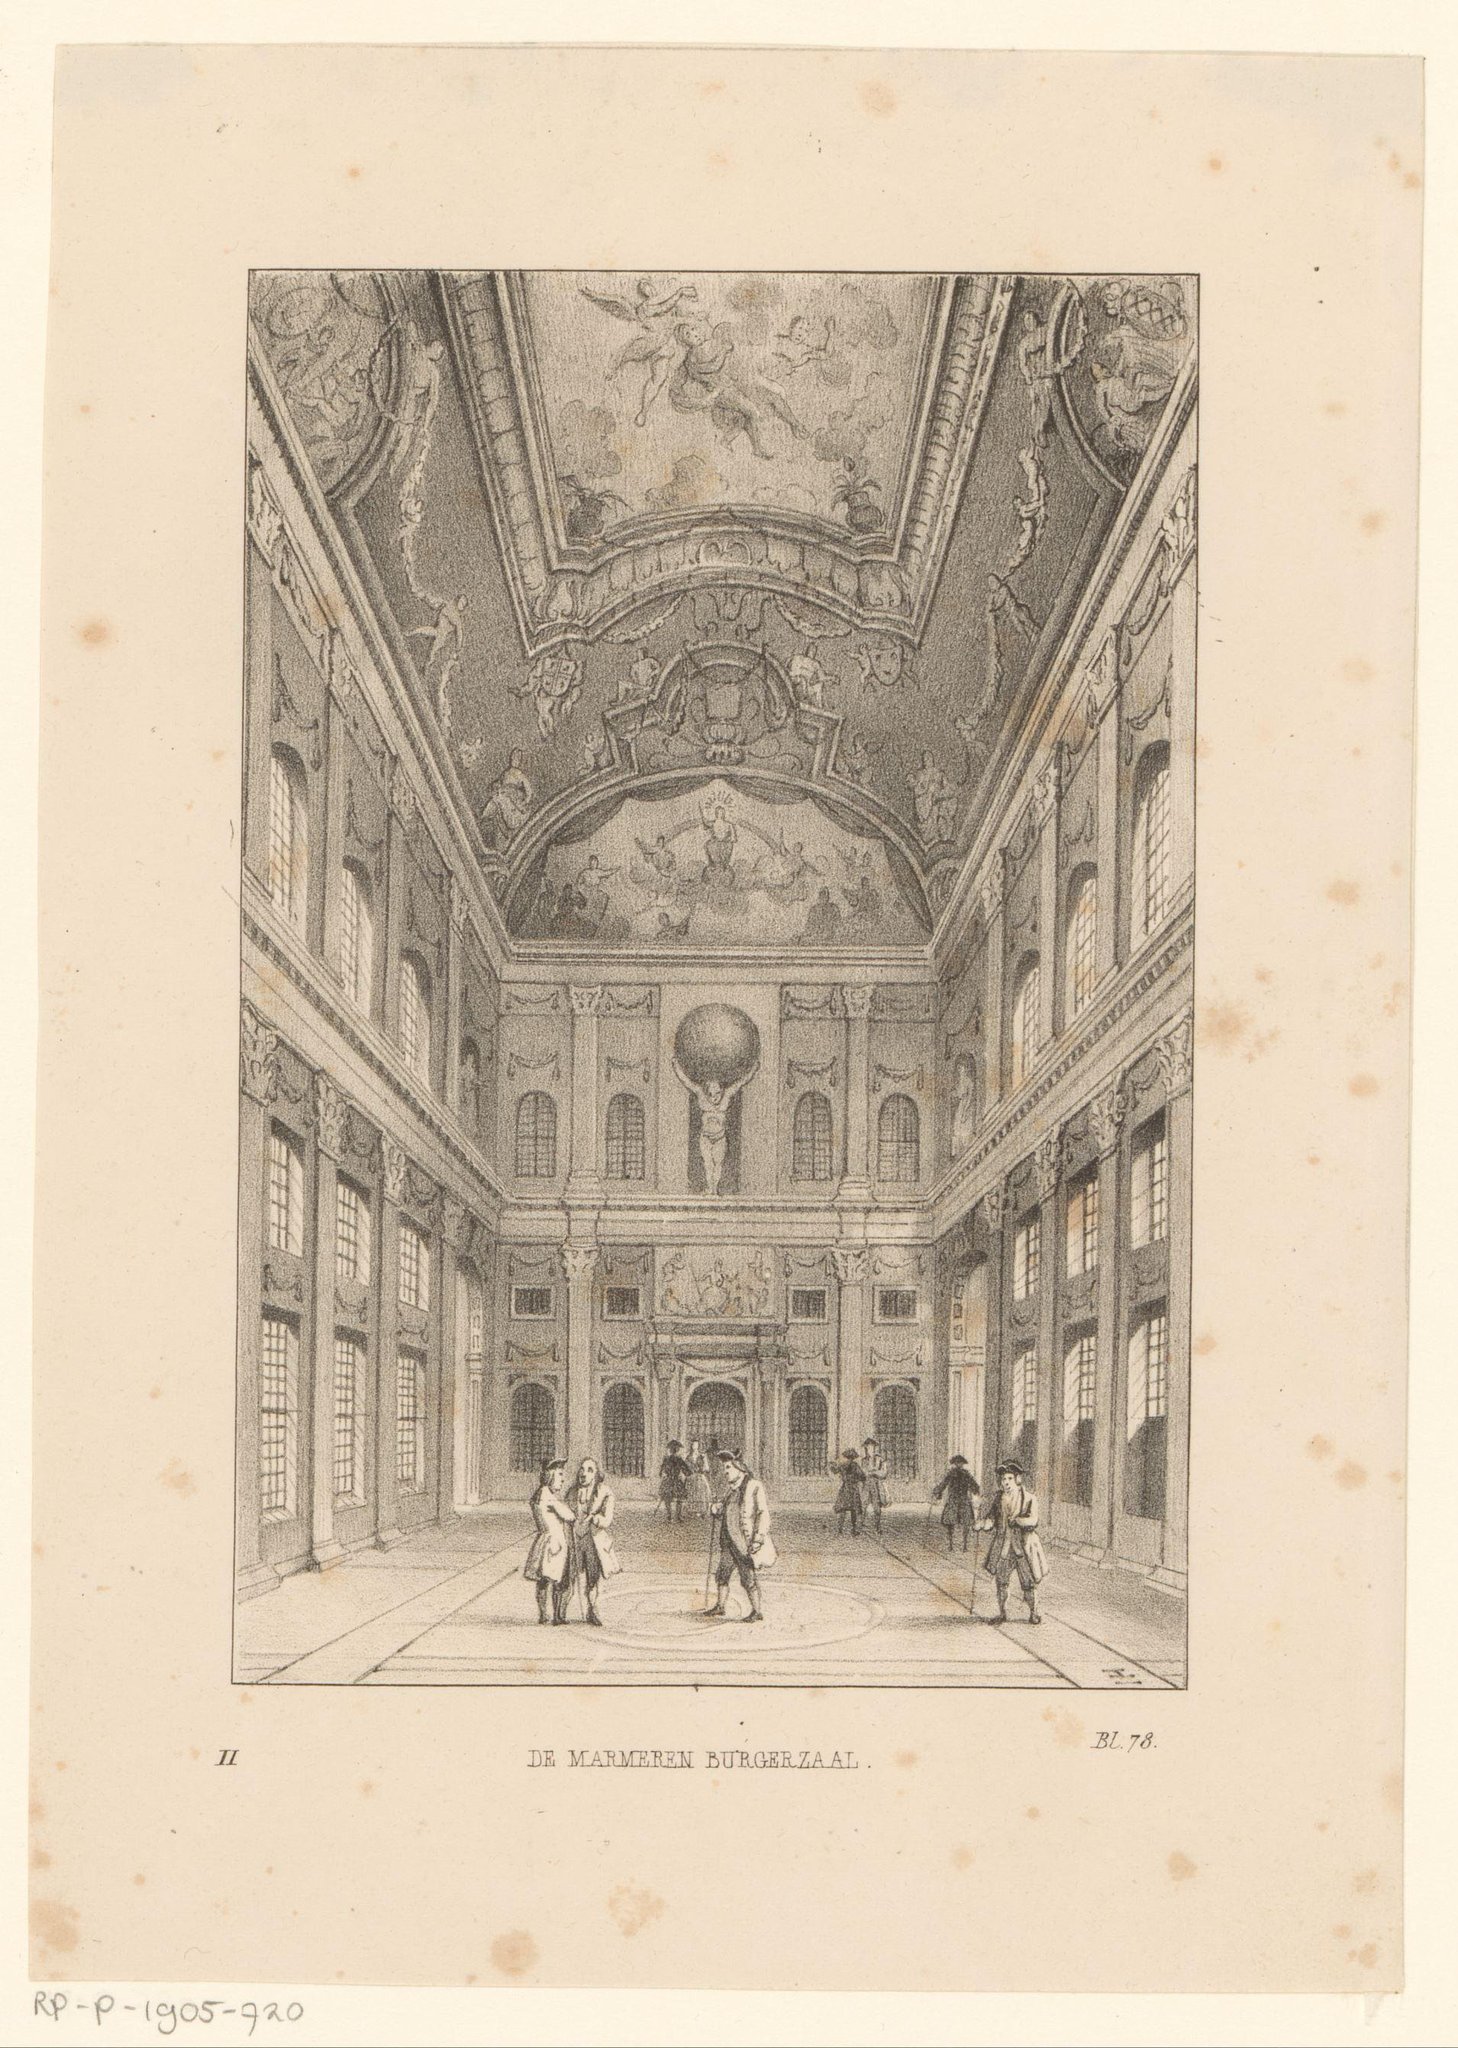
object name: book illustration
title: Gezicht op de burgerzaal van het Koninklijk Paleis in Amsterdam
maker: johannes hilverdink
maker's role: draughtsman, painter, print maker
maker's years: 1813-1902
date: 1844-1848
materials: paper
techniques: lithograph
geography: amsterdam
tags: assembly-room, (decorated) ceiling, royal palace of amsterdam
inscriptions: collector's mark: Lugt 2228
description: Prent uit: Vijver, C. van der. Geschiedkundige beschrijving der stad Amsterdam. Amsterdam: Diederichs, Gebroeders, 1844-1848.